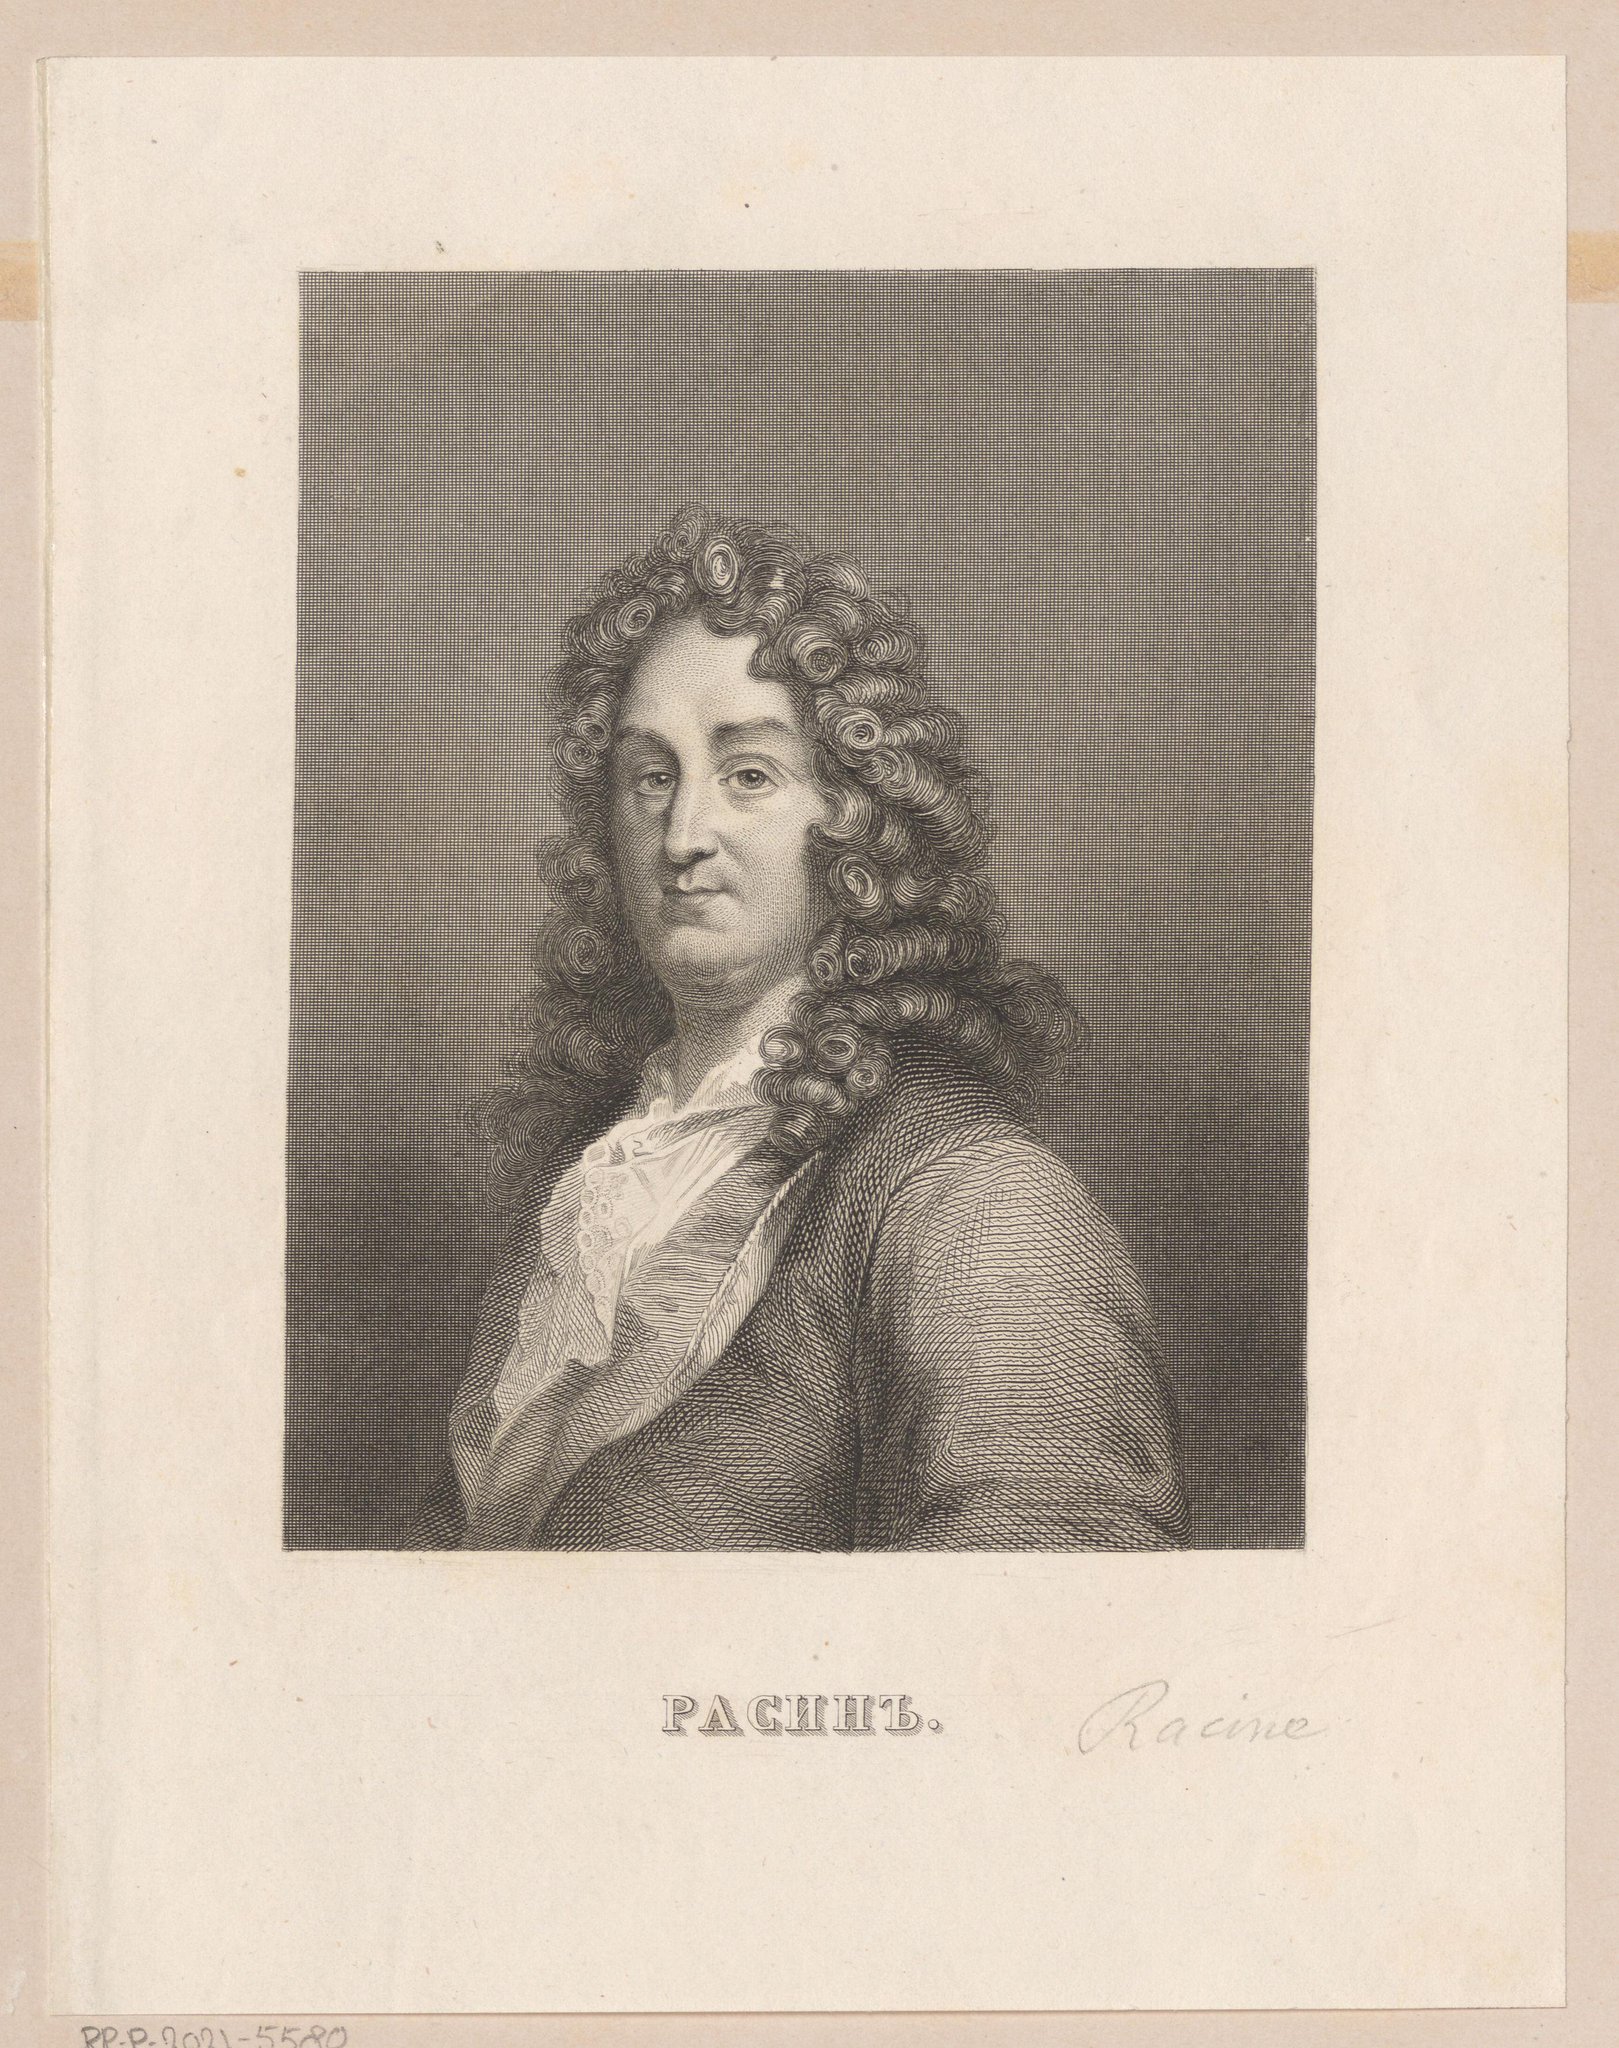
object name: print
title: Portret van Jean Racine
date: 1800-1899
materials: paper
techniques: engraving, etching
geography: emmerik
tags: france, paris, jean racine, historical persons